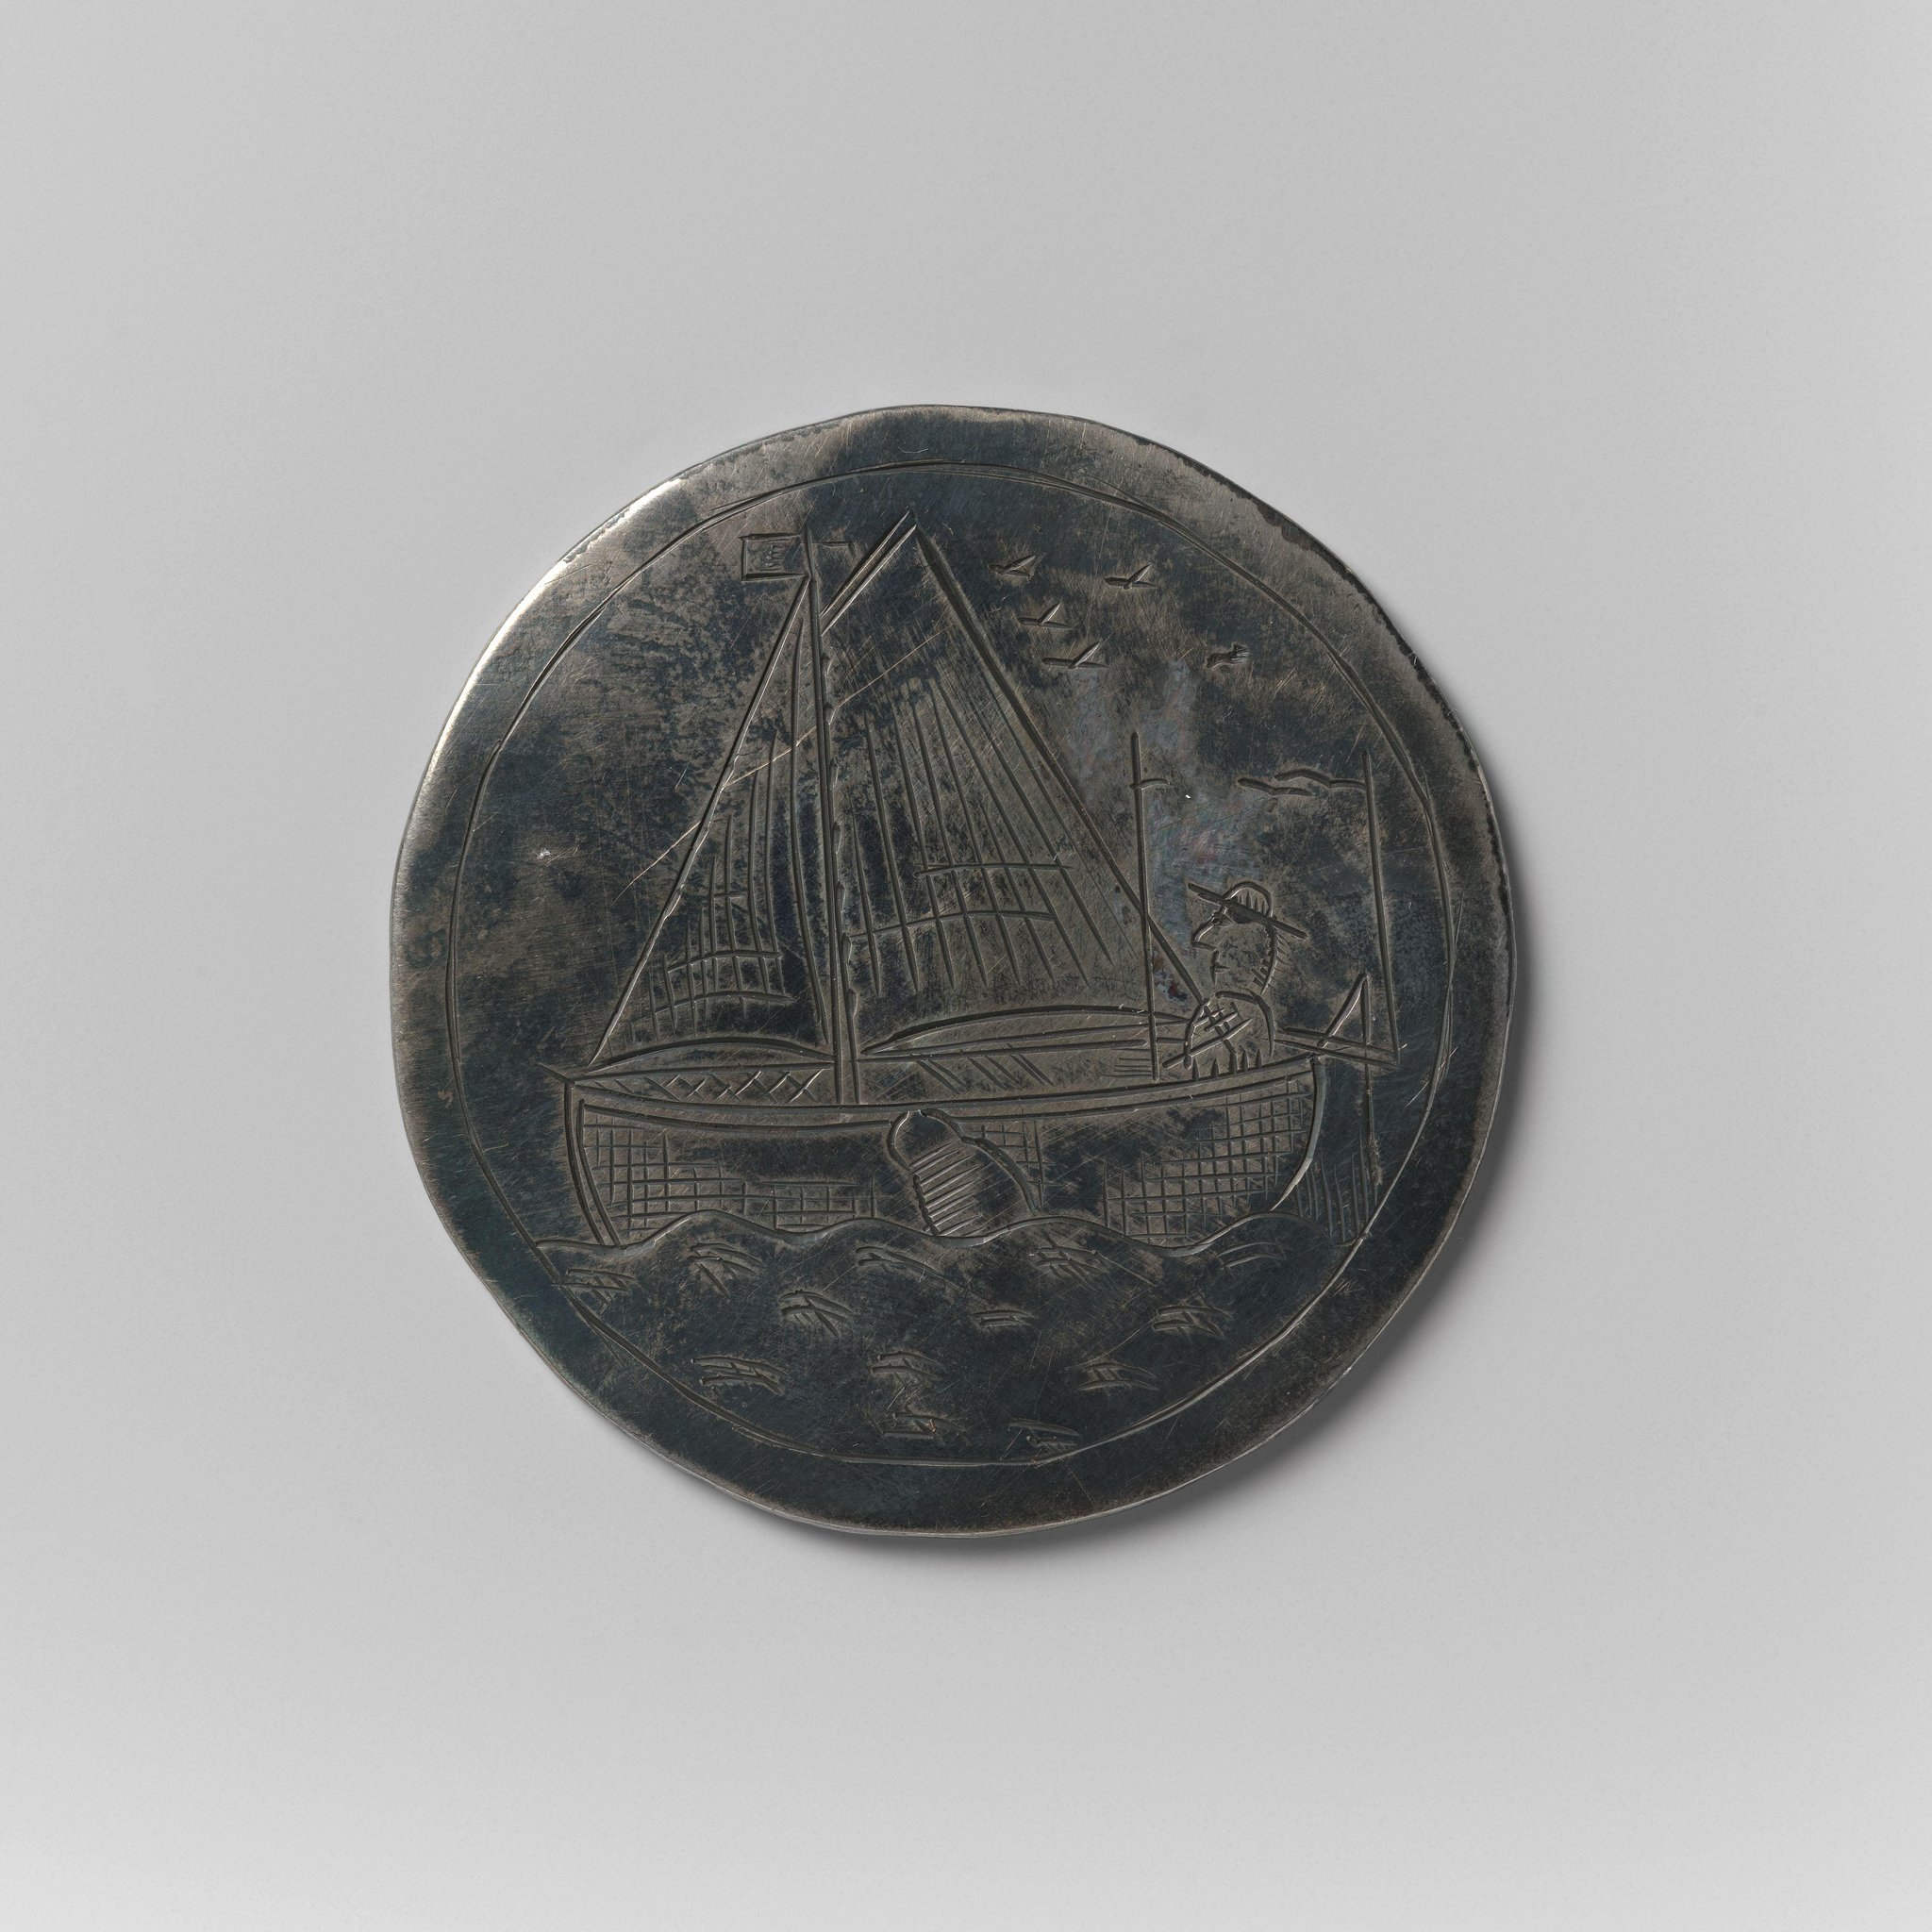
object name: medal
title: Overmanspenning van het Roei-, Steiger- en Schuitenvoerdersgilde te Amsterdam (Herberg Steiger), 1749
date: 1659-1749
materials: silver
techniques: engraving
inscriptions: inscription: ‘1749 / den 18 Octob / Barent / Schuyderes / (BS-merk tussen HE - S)’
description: Ronde plaat zilver gegraveerd op de voorzijde een man in een zeilscheepje naar links, op de keerzijde vijf regels tekst, op naam van Barent Schuyderes 18 oktober 1749